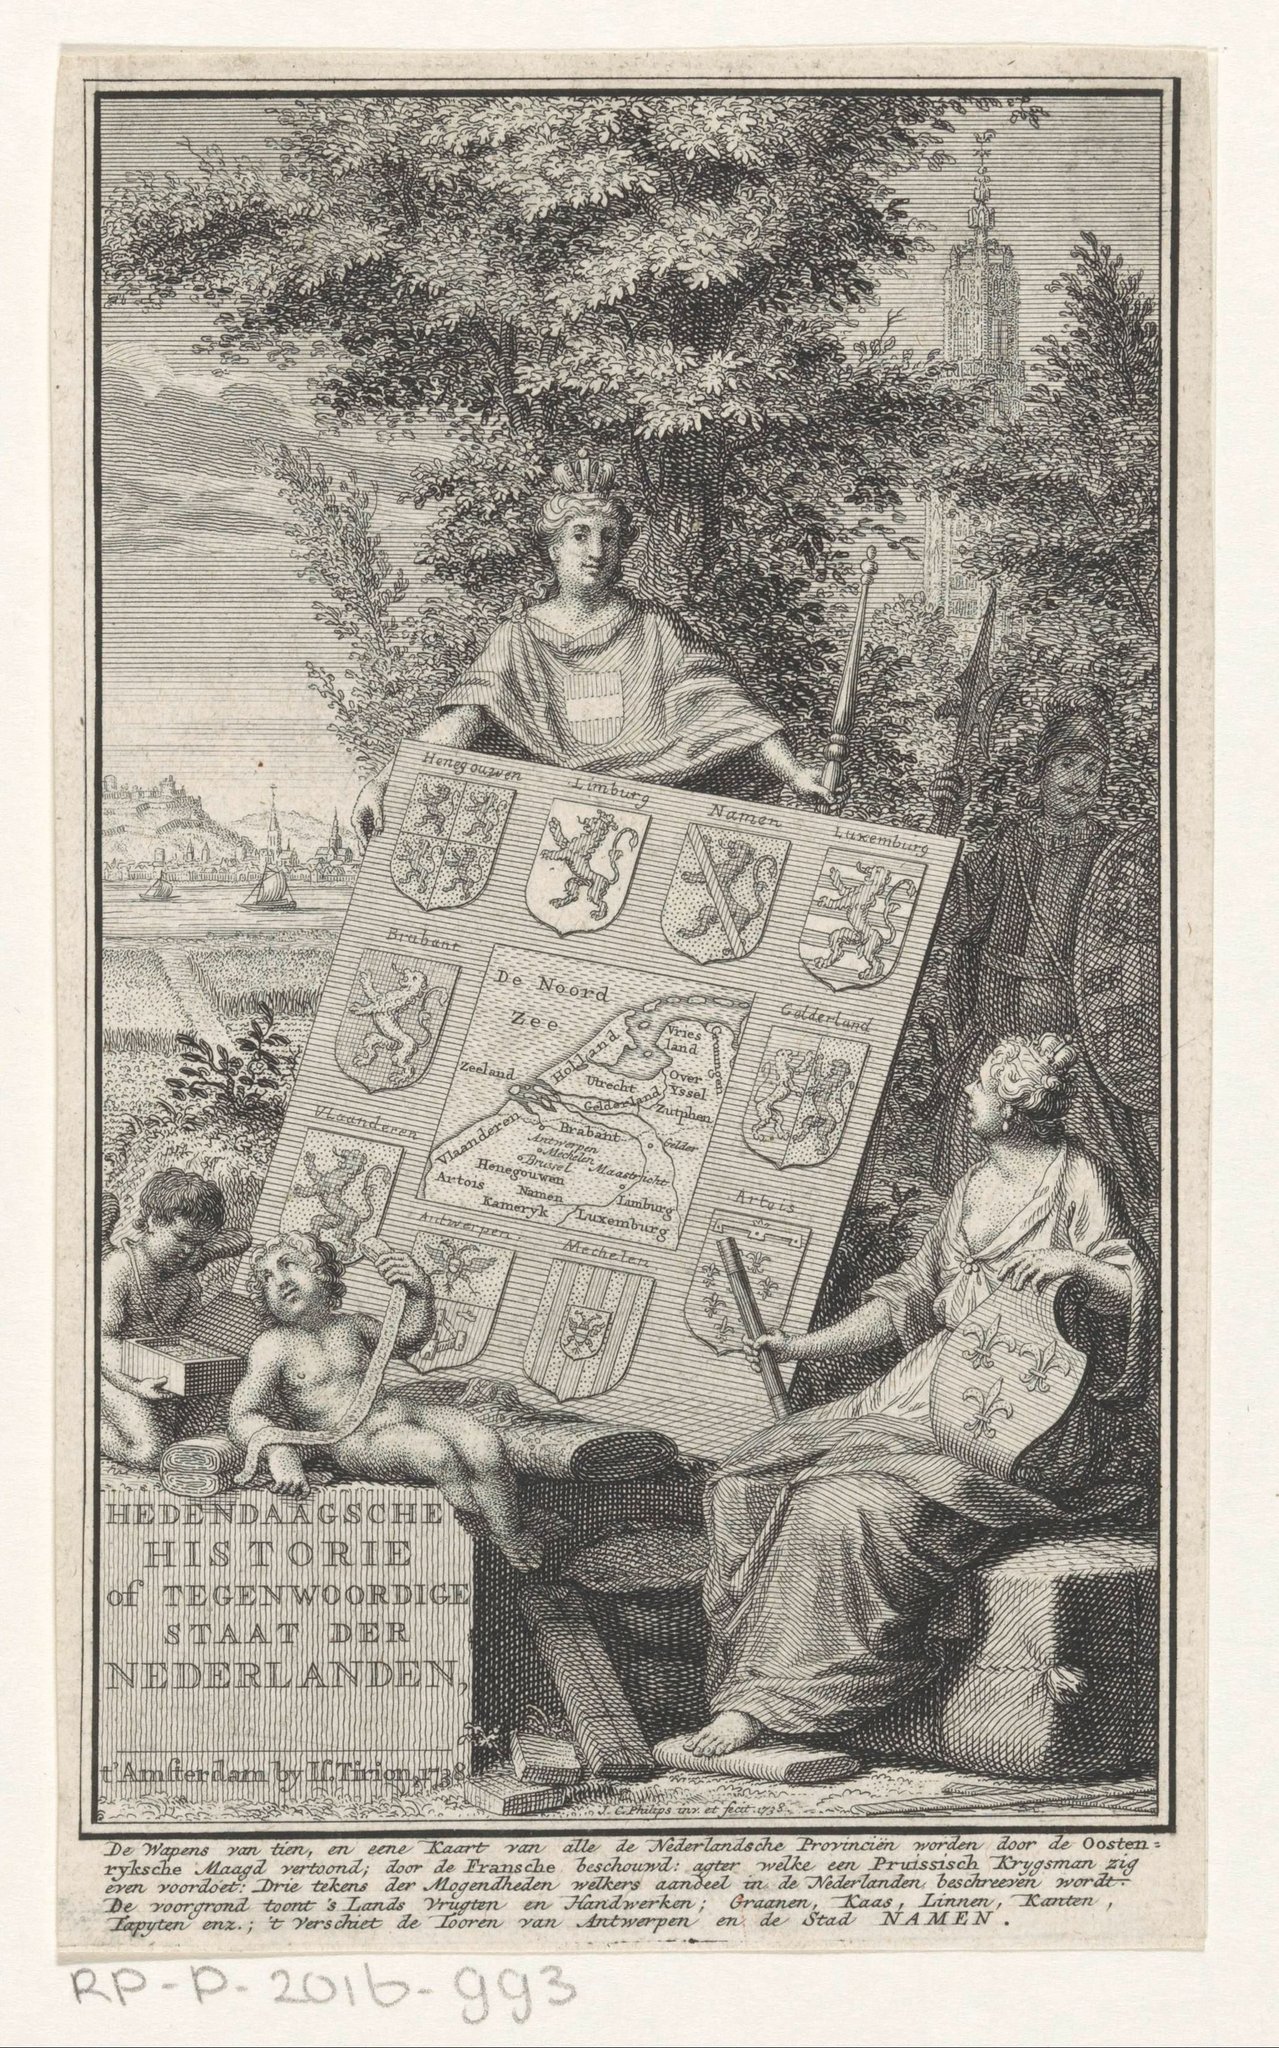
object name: print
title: Oostenrijkse Maagd met de wapenschilden van tien Nederlandse Provincieën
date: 1738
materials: paper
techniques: engraving, etching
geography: amsterdam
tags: personifications of countries, nations, states, districts, etc., coat of arms (as symbol of the state, etc.) (+ province; provincial), austria, france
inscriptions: collector's mark: Lugt 2228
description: Titelpagina voor: Wagenaar, Jan. Hedendaagsche historie of tegenwoordige staat der Oostenryksche, Fransche en Pruissische Nederlanden, deel X. Amsterdam: Tirion, Isaak, 1738. Prent afkomstig uit een plakalbum met titelprenten, ornamenten etc. op blauw papier in 1983 uit elkaar gehaald. Volgens een notitie op verso zat de prent op p. 195 van dit album.